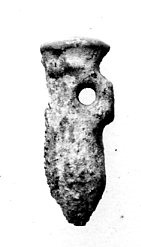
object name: amulet, papyrus column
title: Papyrus column amulet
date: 664-332 BCE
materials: faience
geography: egypt